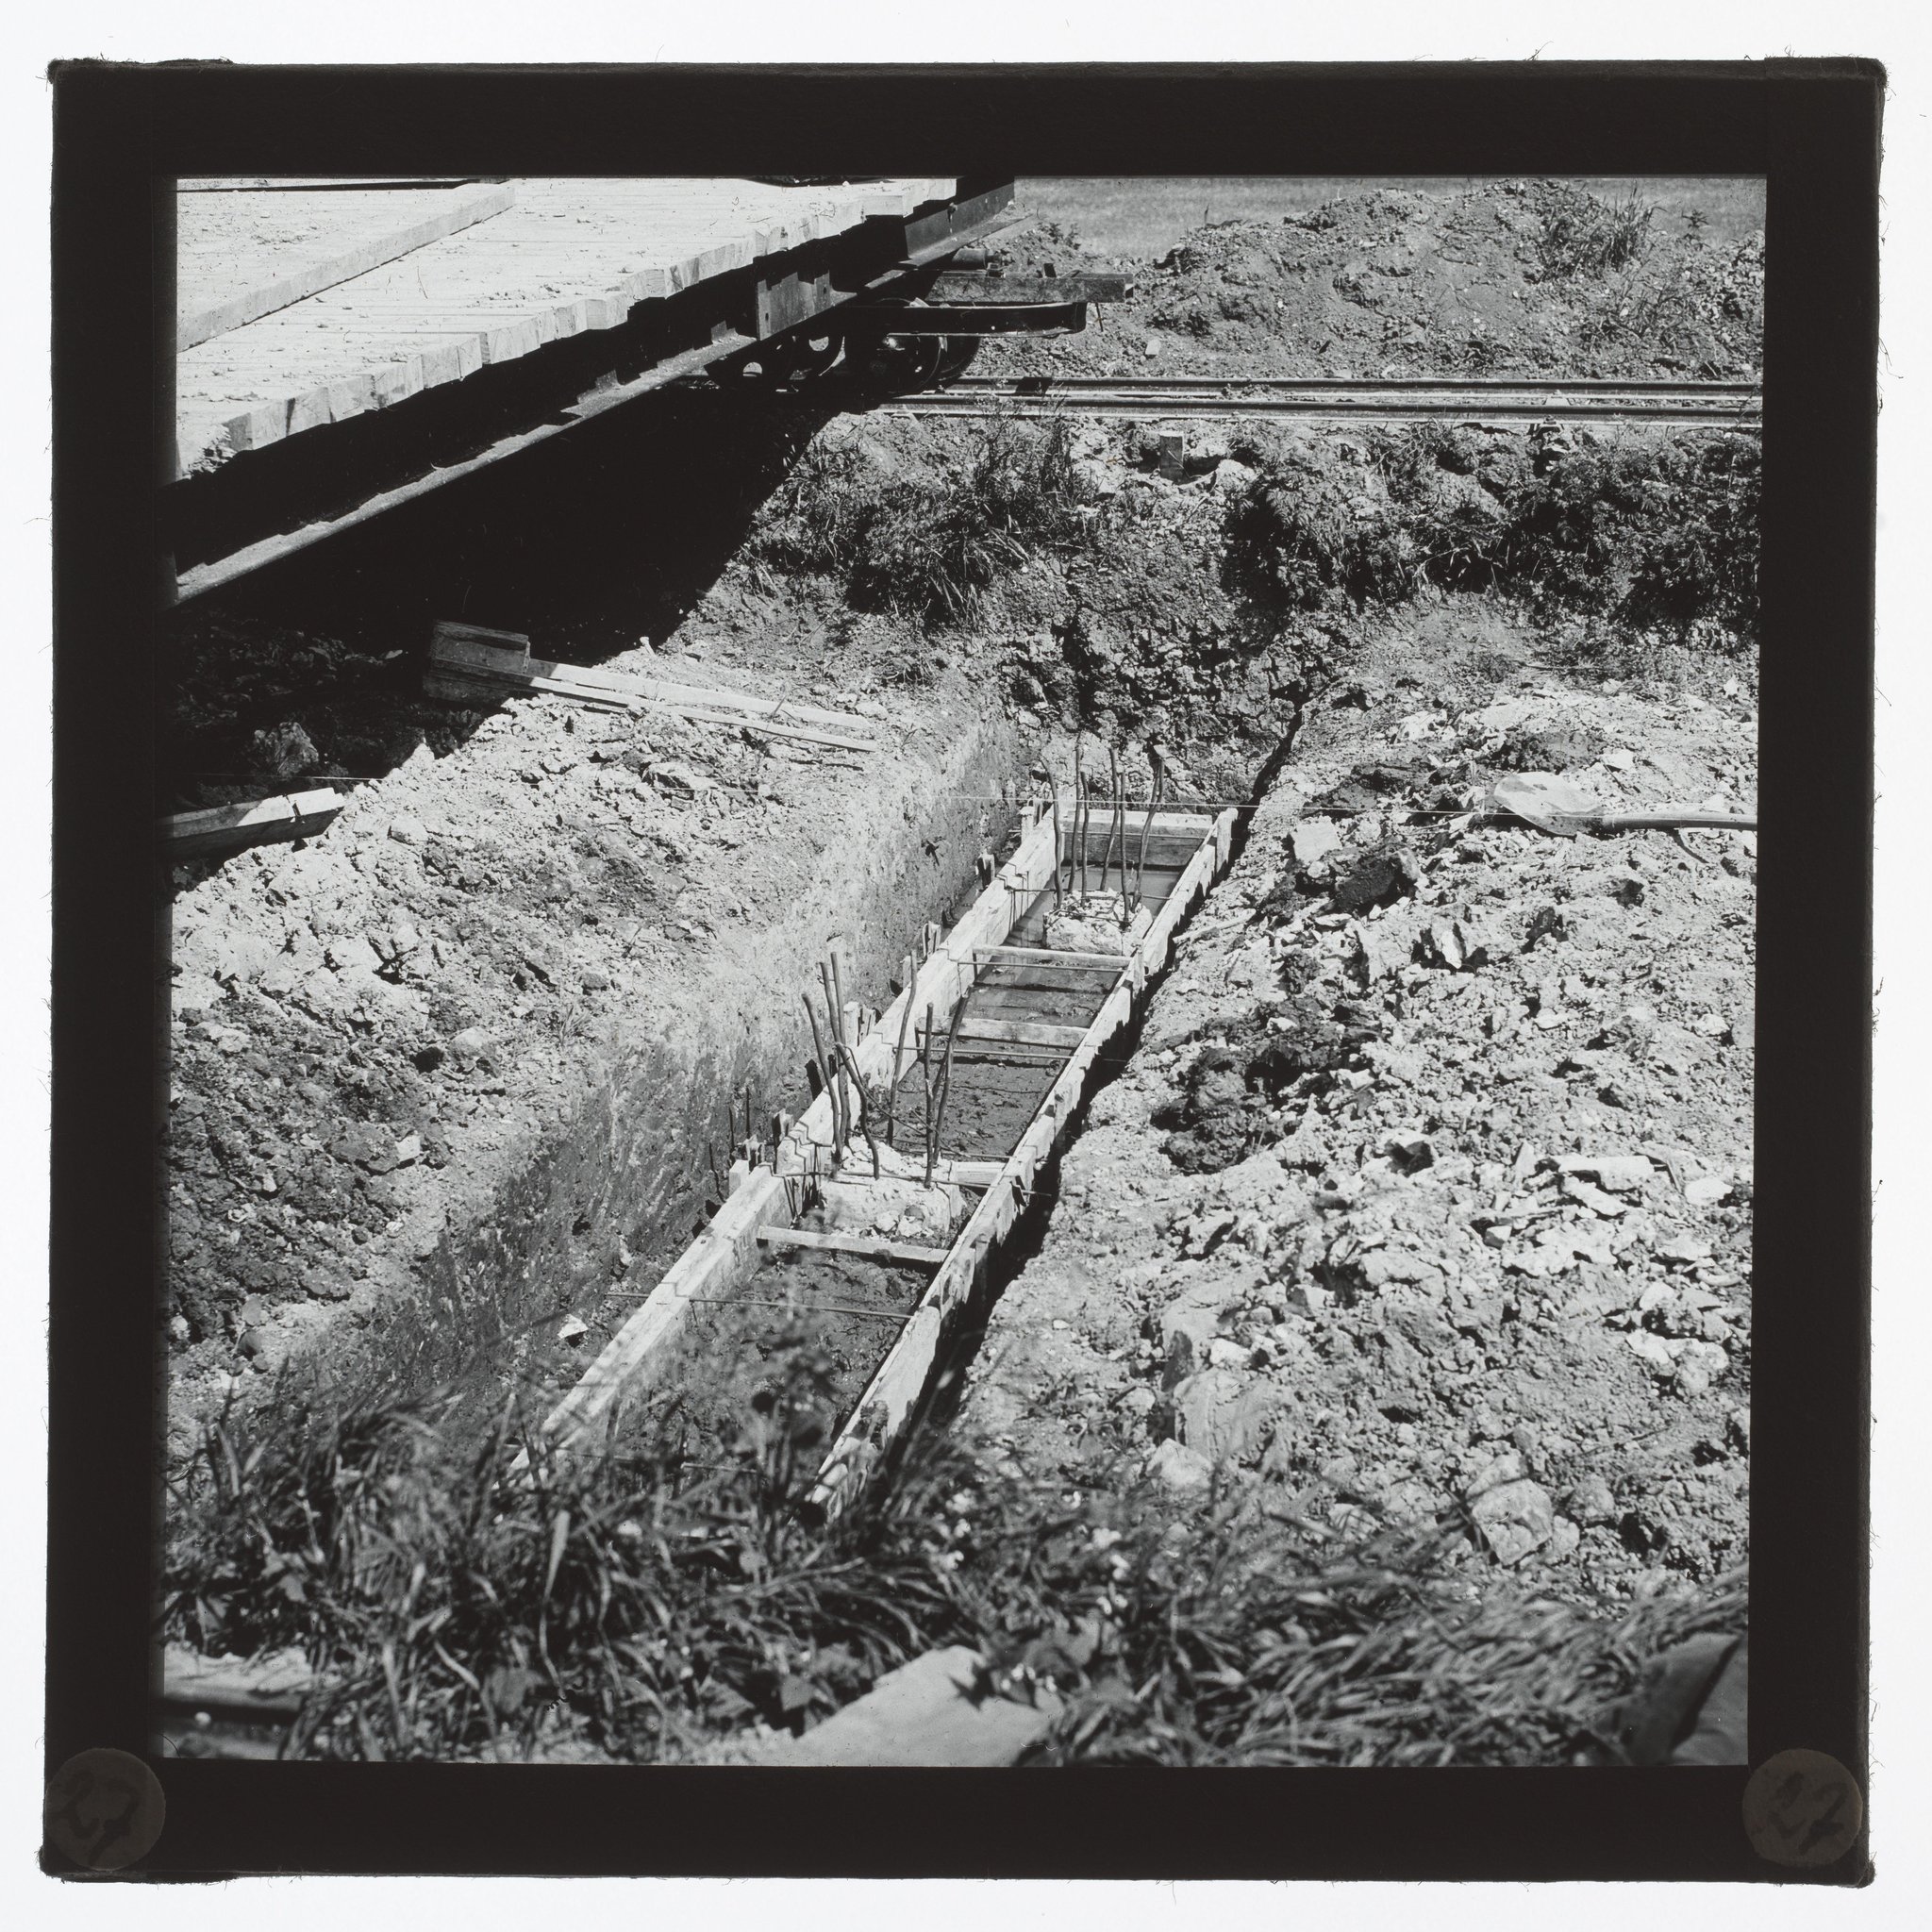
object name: lantern slide photographic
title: Bouwplaats, Zuid-Holland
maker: Anonymous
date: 1956-1960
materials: glass, paper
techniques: gelatin silver transparency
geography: south holland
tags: building-site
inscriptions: number: ‘27’